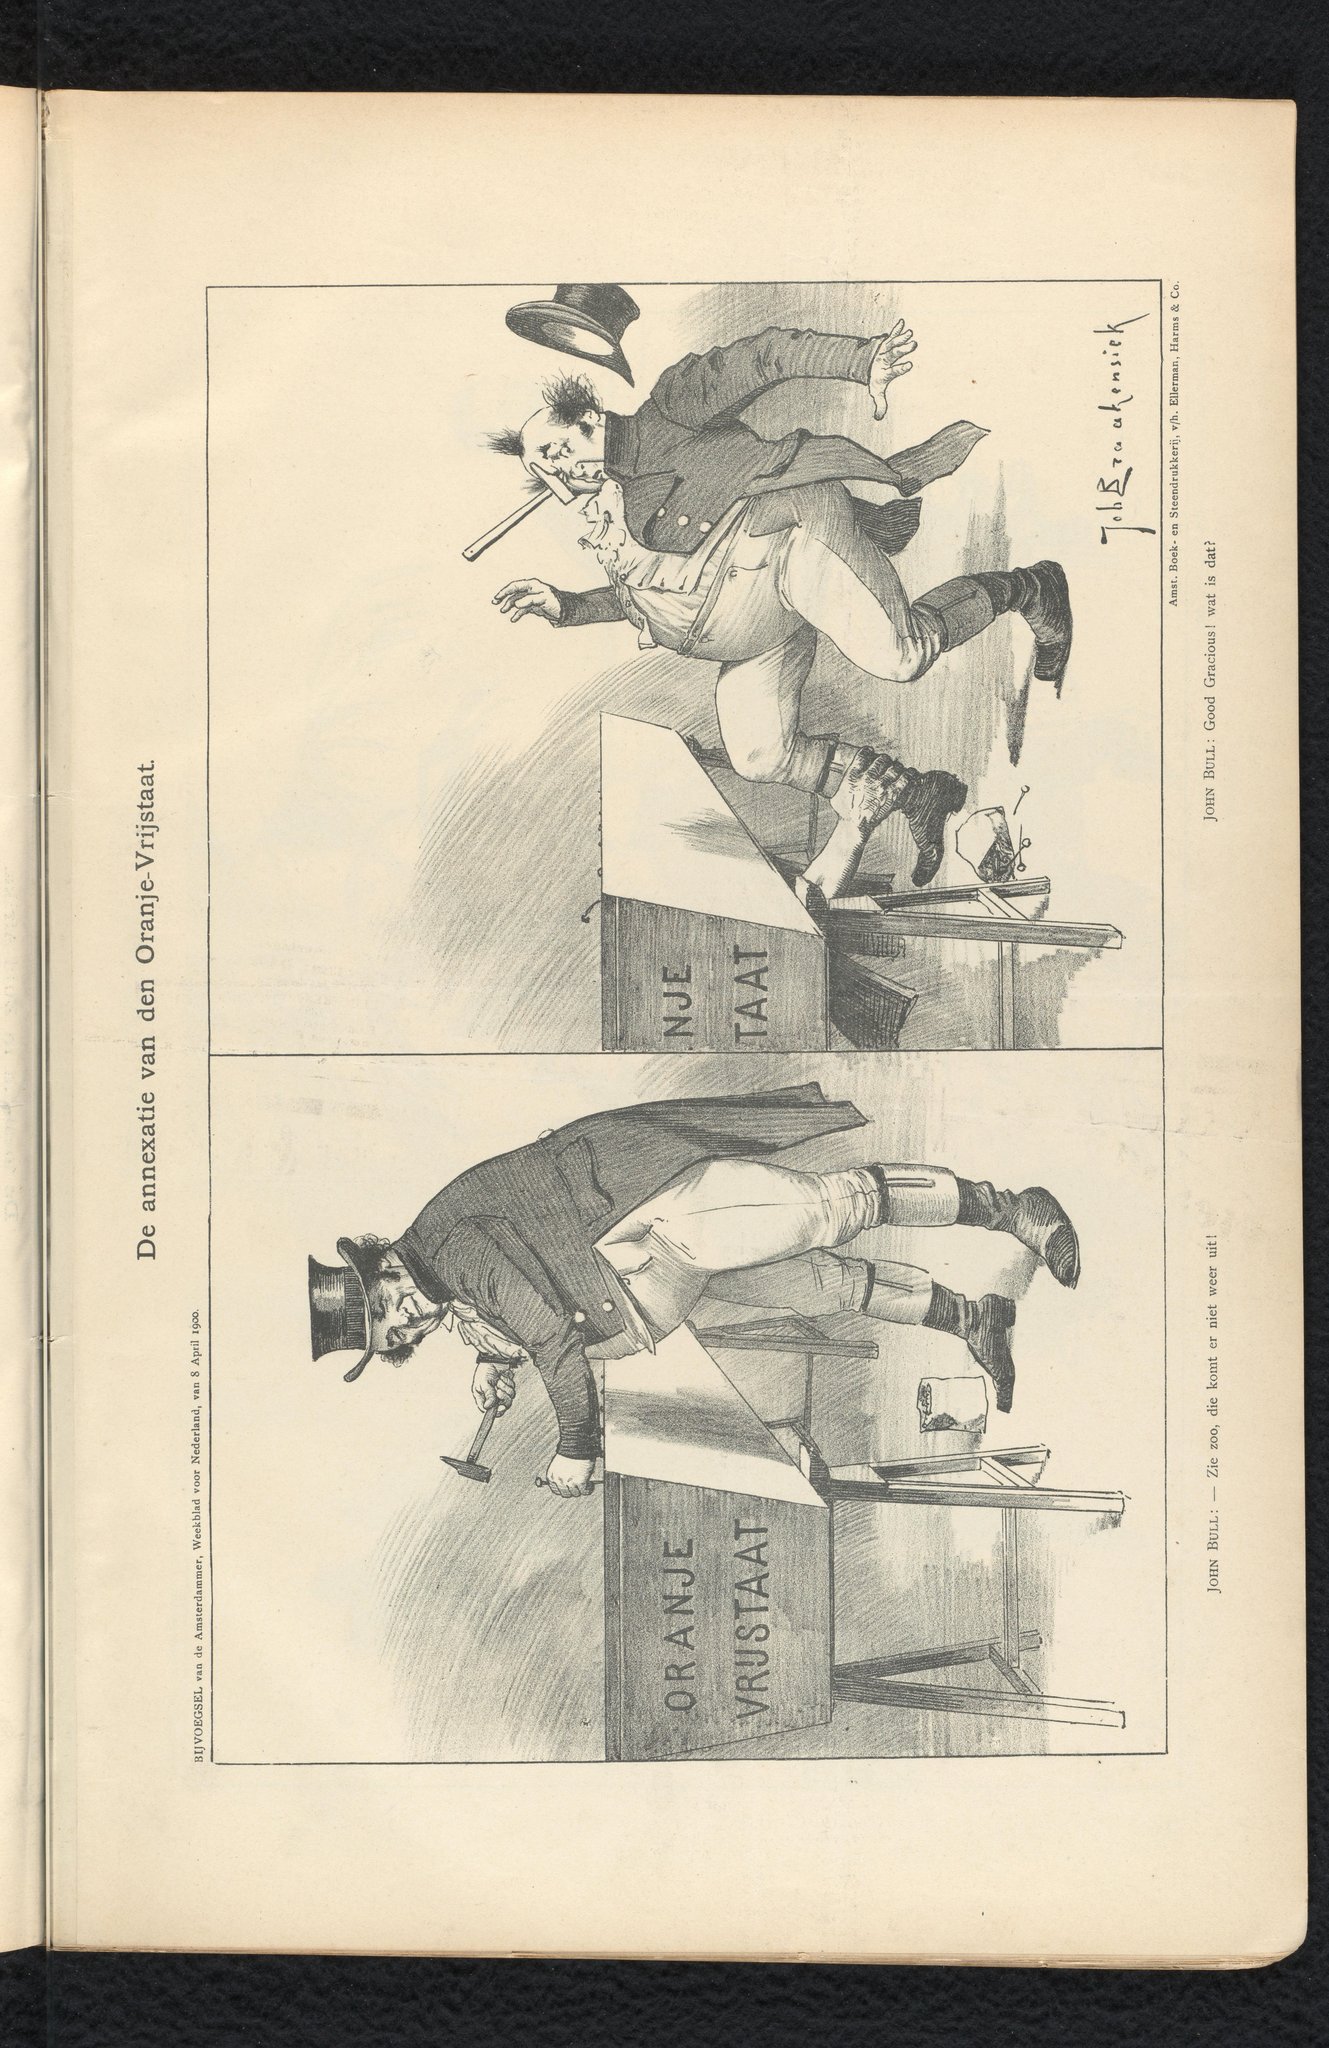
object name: cartoon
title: De annexatie van den Oranje-Vrijstaat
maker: johan braakensiek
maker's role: draughtsman, print maker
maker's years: 1858-1940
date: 1900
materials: paper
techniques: lithograph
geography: amsterdam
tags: personifications of countries, nations, states, districts, etc., coffin, political caricatures and satires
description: John Bull (Engeland) slaat een spijker in de doodskist van Oranje Vrijstaat maar wordt door een hand uit de kist gegrepen en krijgt de hamer op zijn neus.